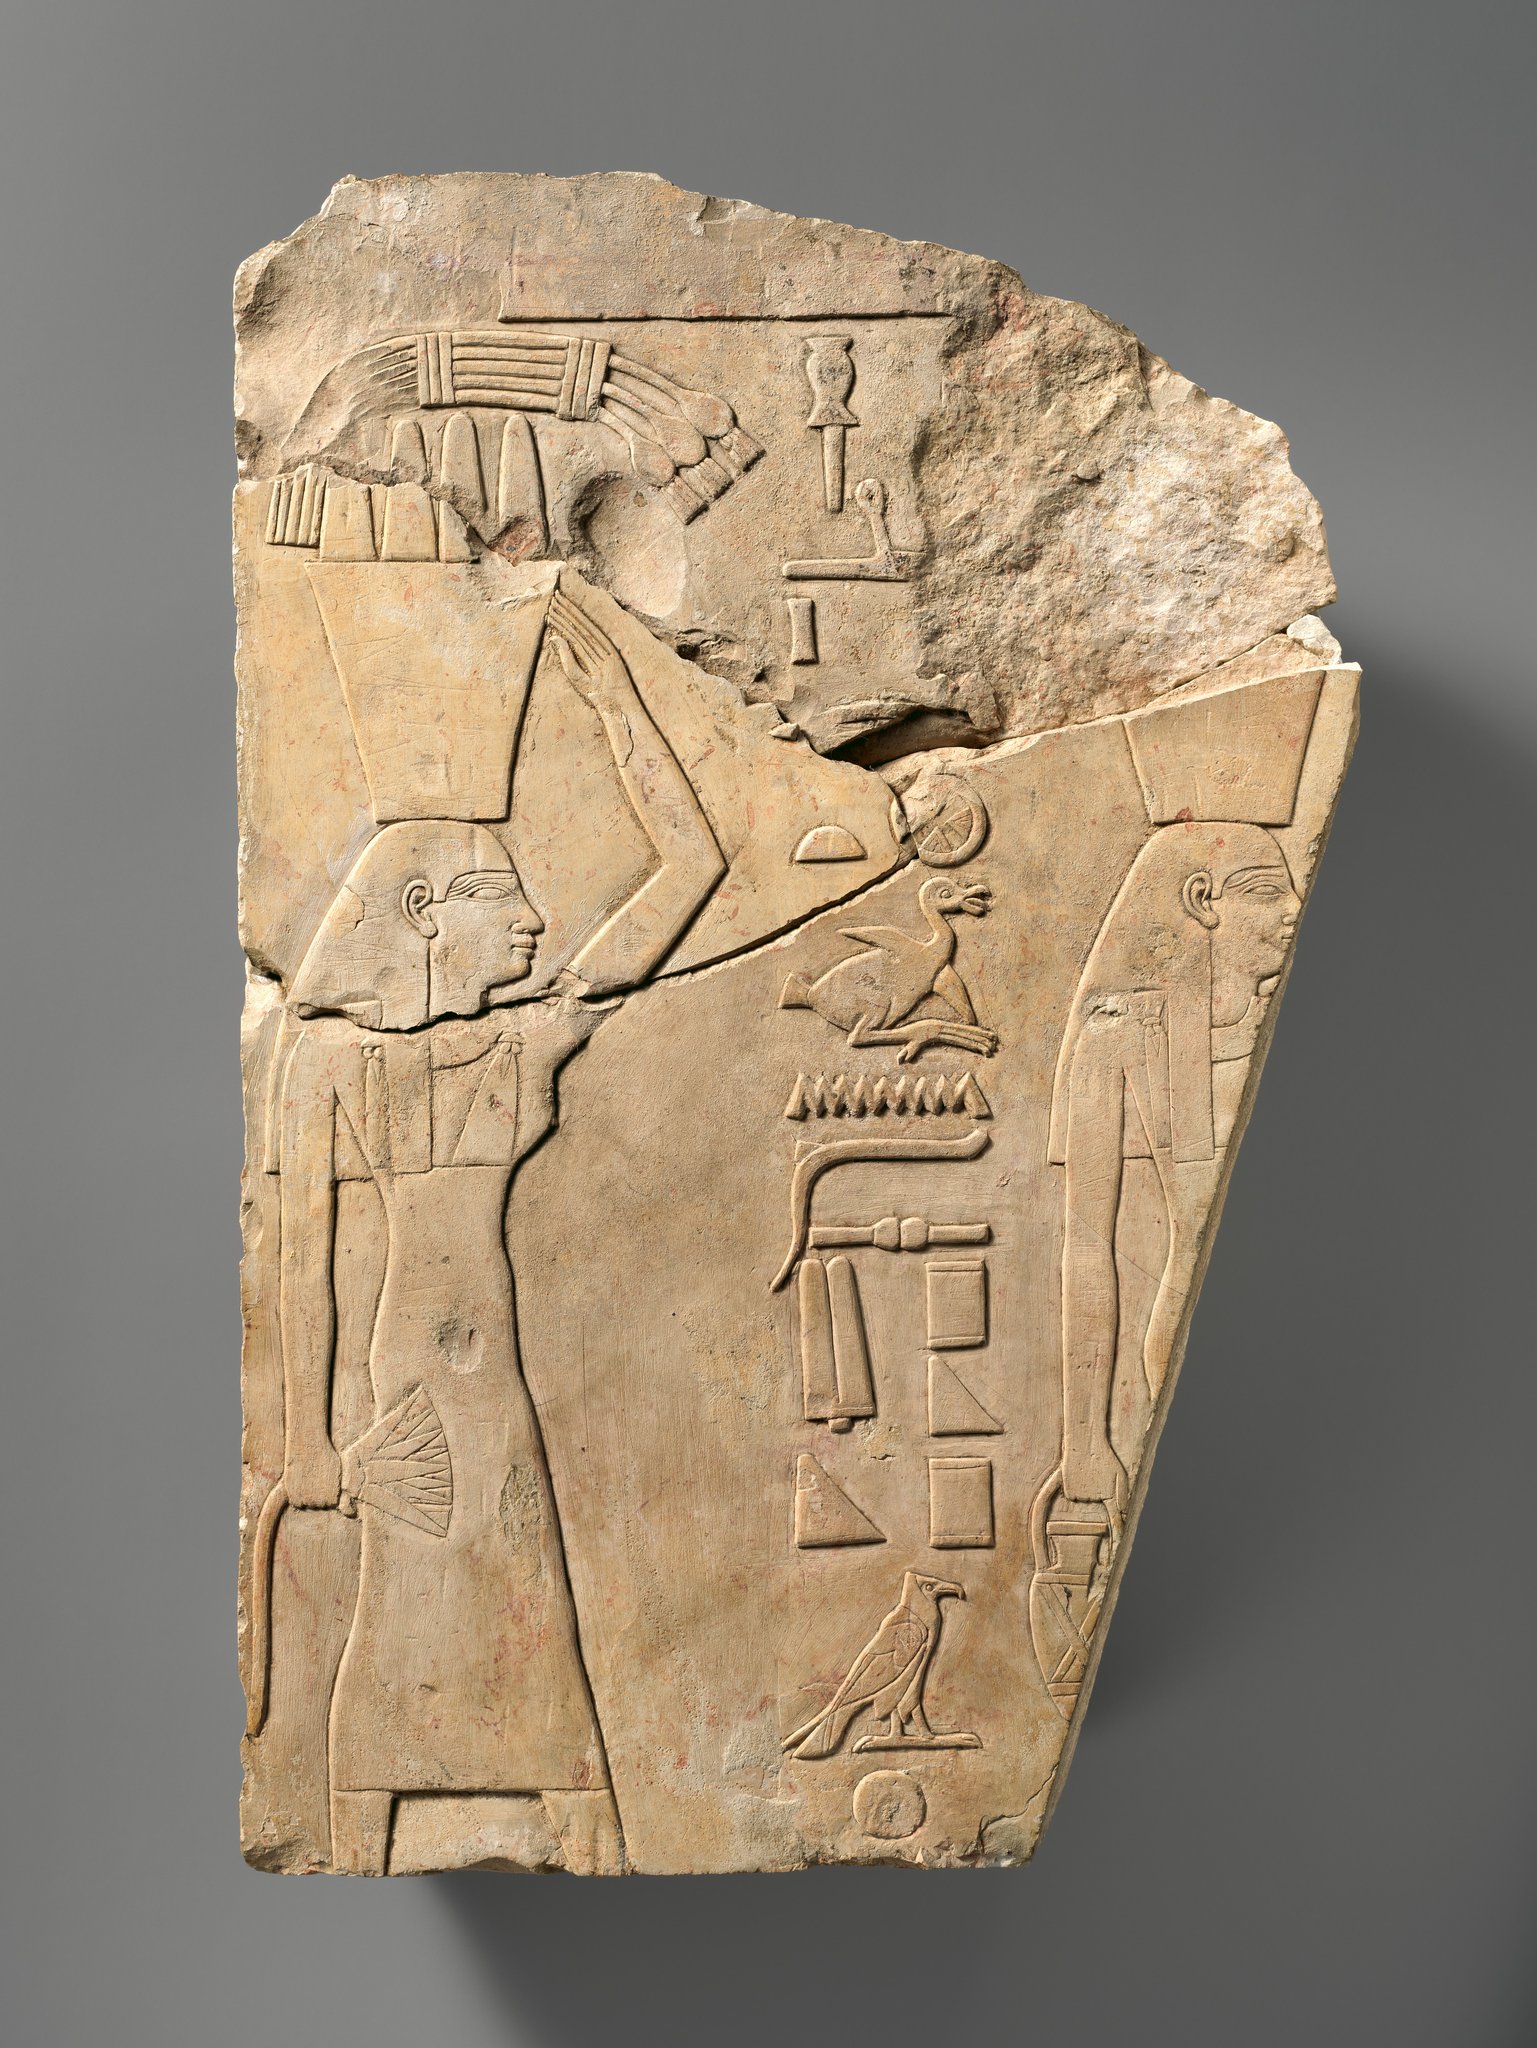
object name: relief, tomb of nespekashuty, head, offering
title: Raised relief fragment with female offering bearers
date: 656-610 BCE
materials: limestone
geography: egypt